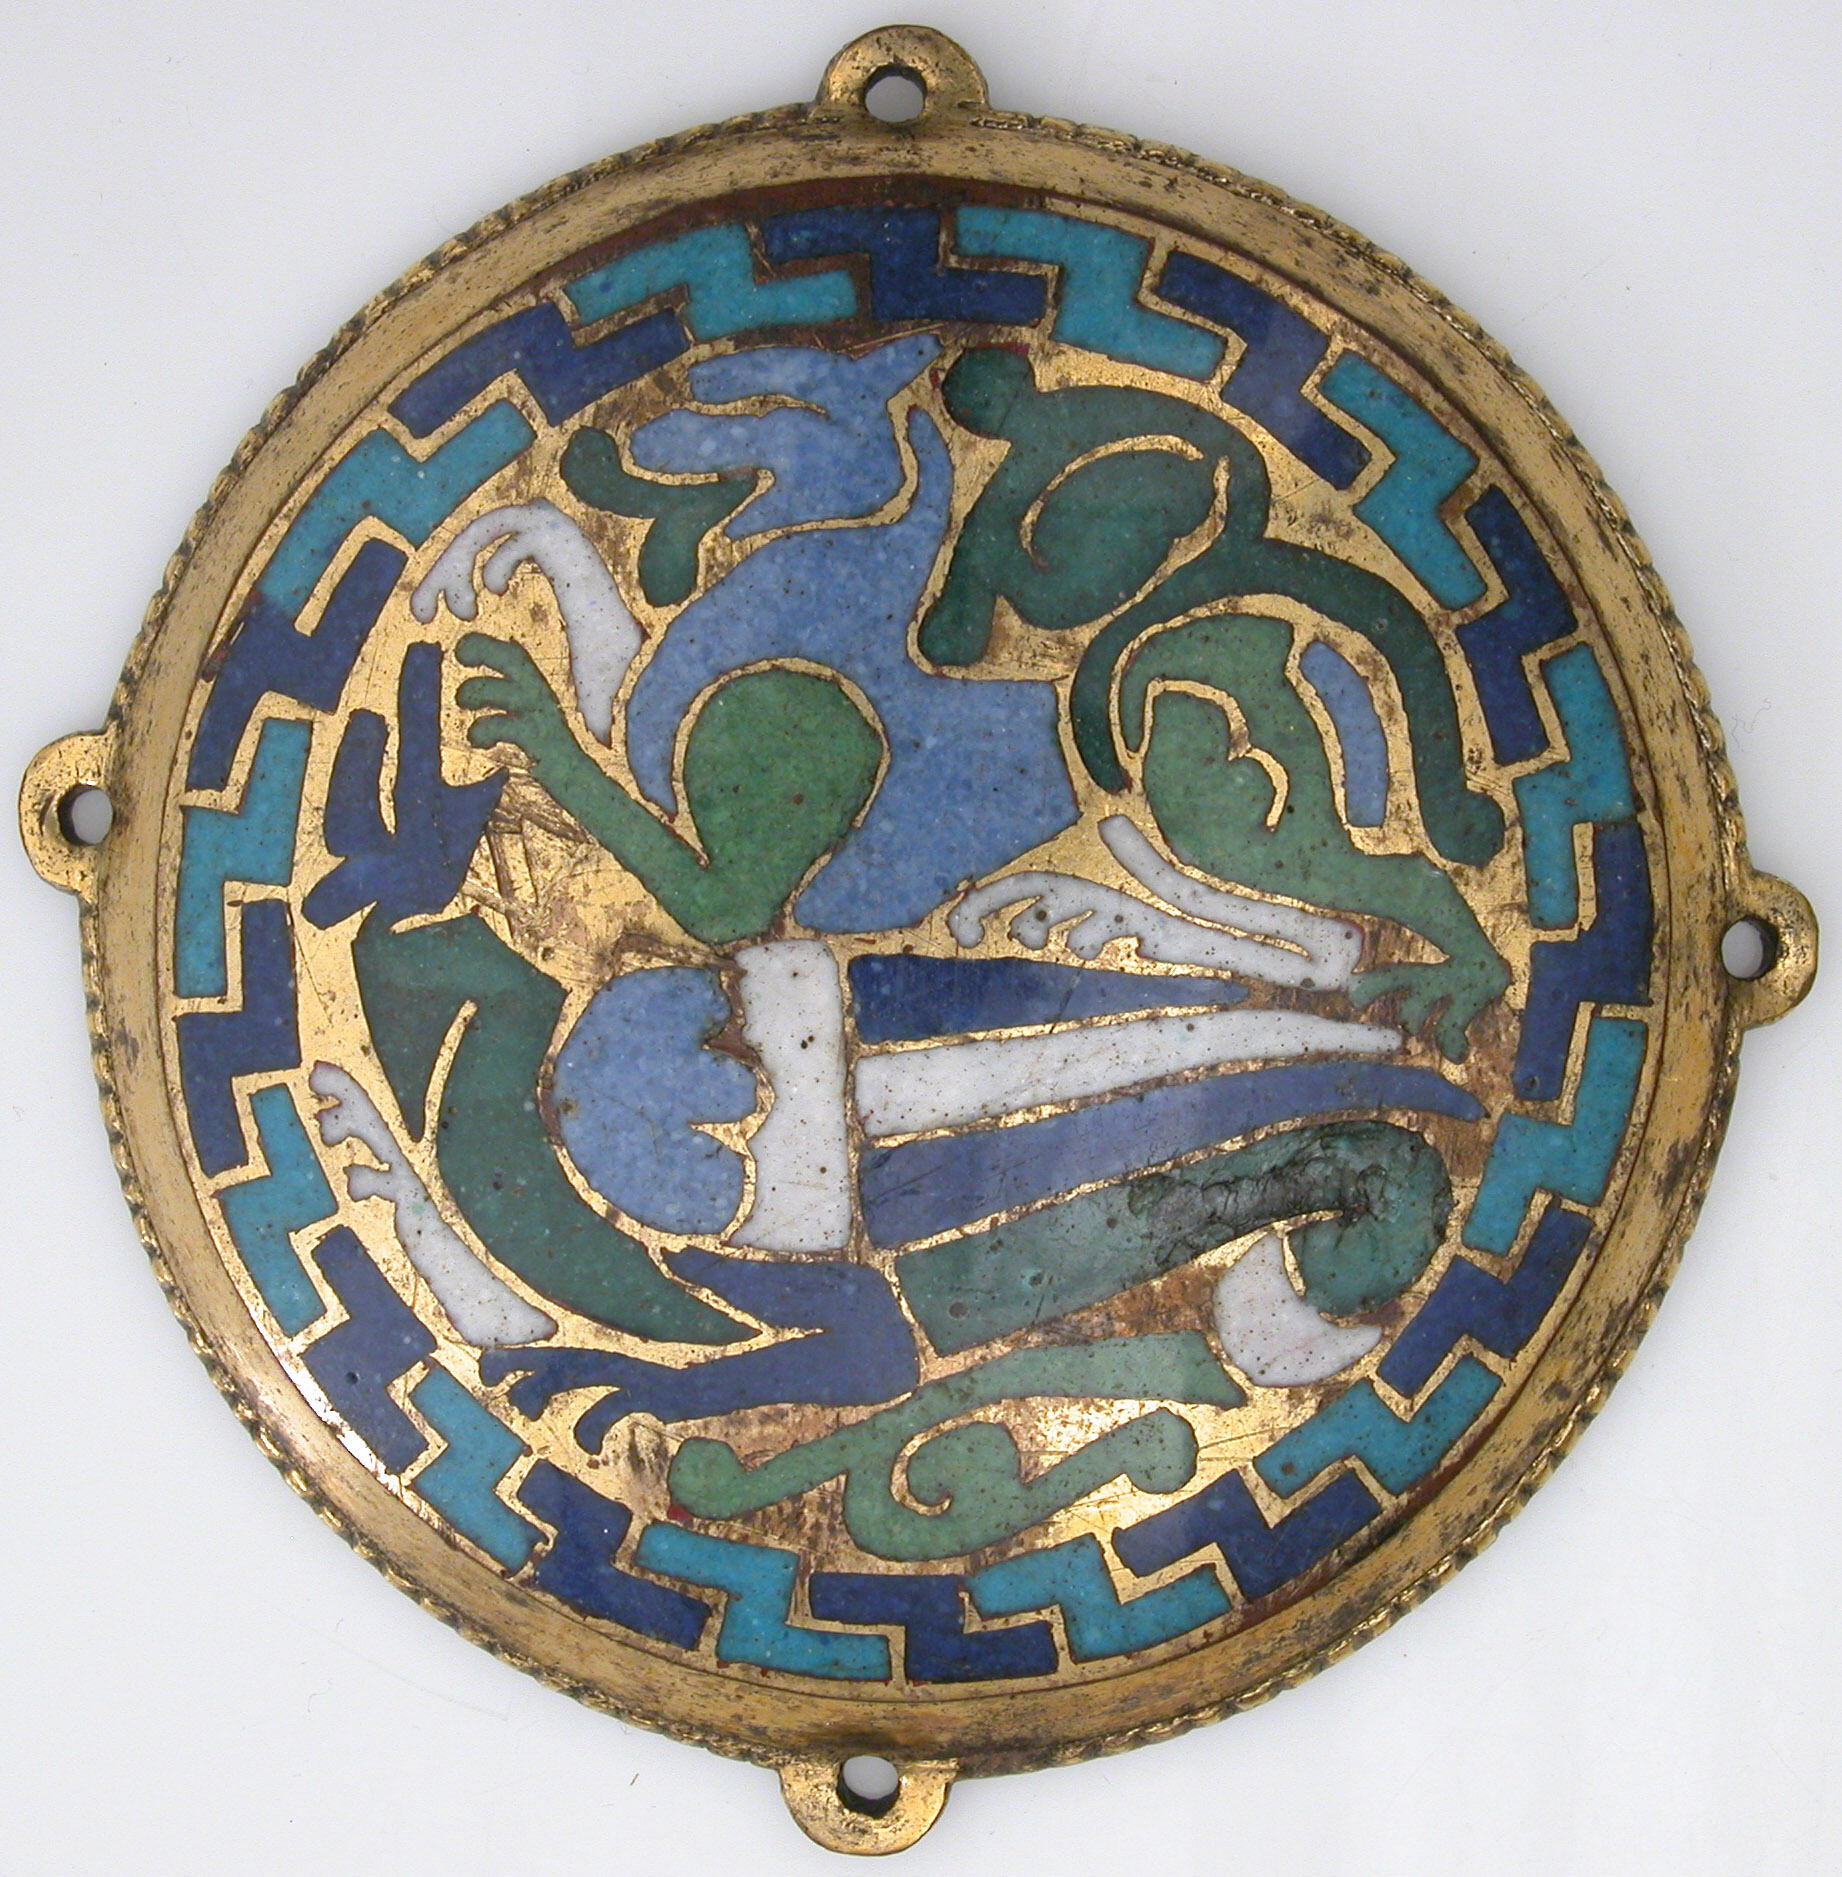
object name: medallion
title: Combat Between Dragon and Dog (one of five medallions from a coffret)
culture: french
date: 1110-1130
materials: gilt copper, enamel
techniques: enamel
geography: france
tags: dragons